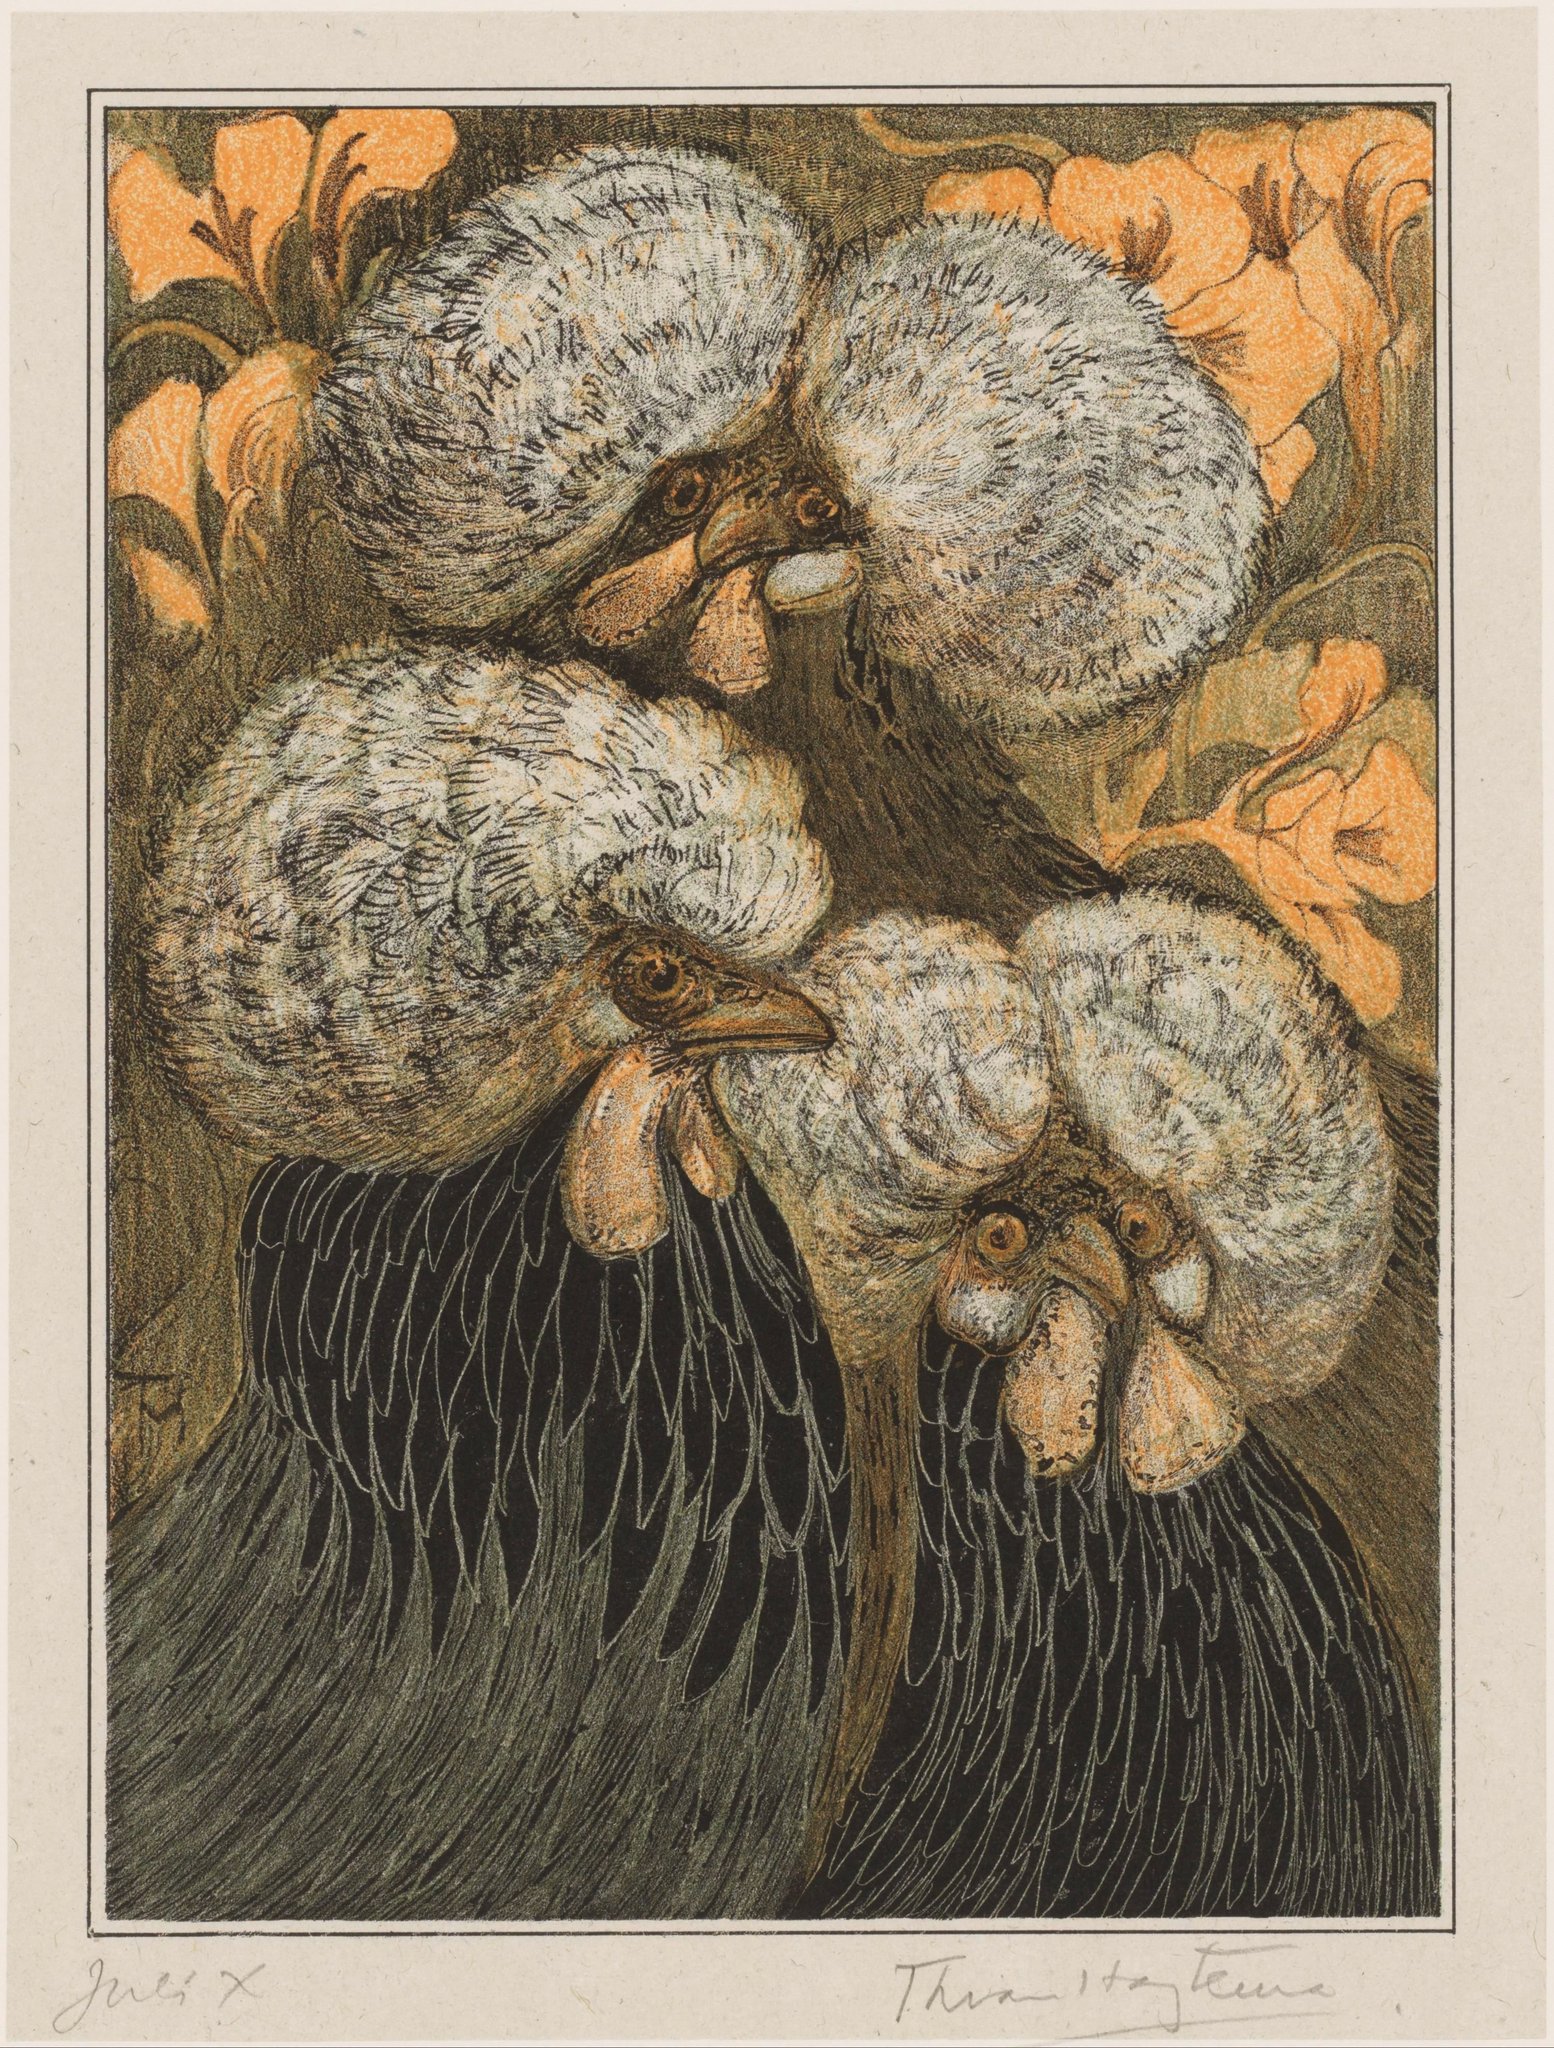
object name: print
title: Drie kuifkippen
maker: theo van hoytema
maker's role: draughtsman, painter, print maker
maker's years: 1863-1917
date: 1878-1910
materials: paper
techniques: lithograph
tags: fowl (cock, hen, chicken, etc.)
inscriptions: collector's mark: Lugt 2233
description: Prent is een proefdruk voor kalenderblad juli 1910.